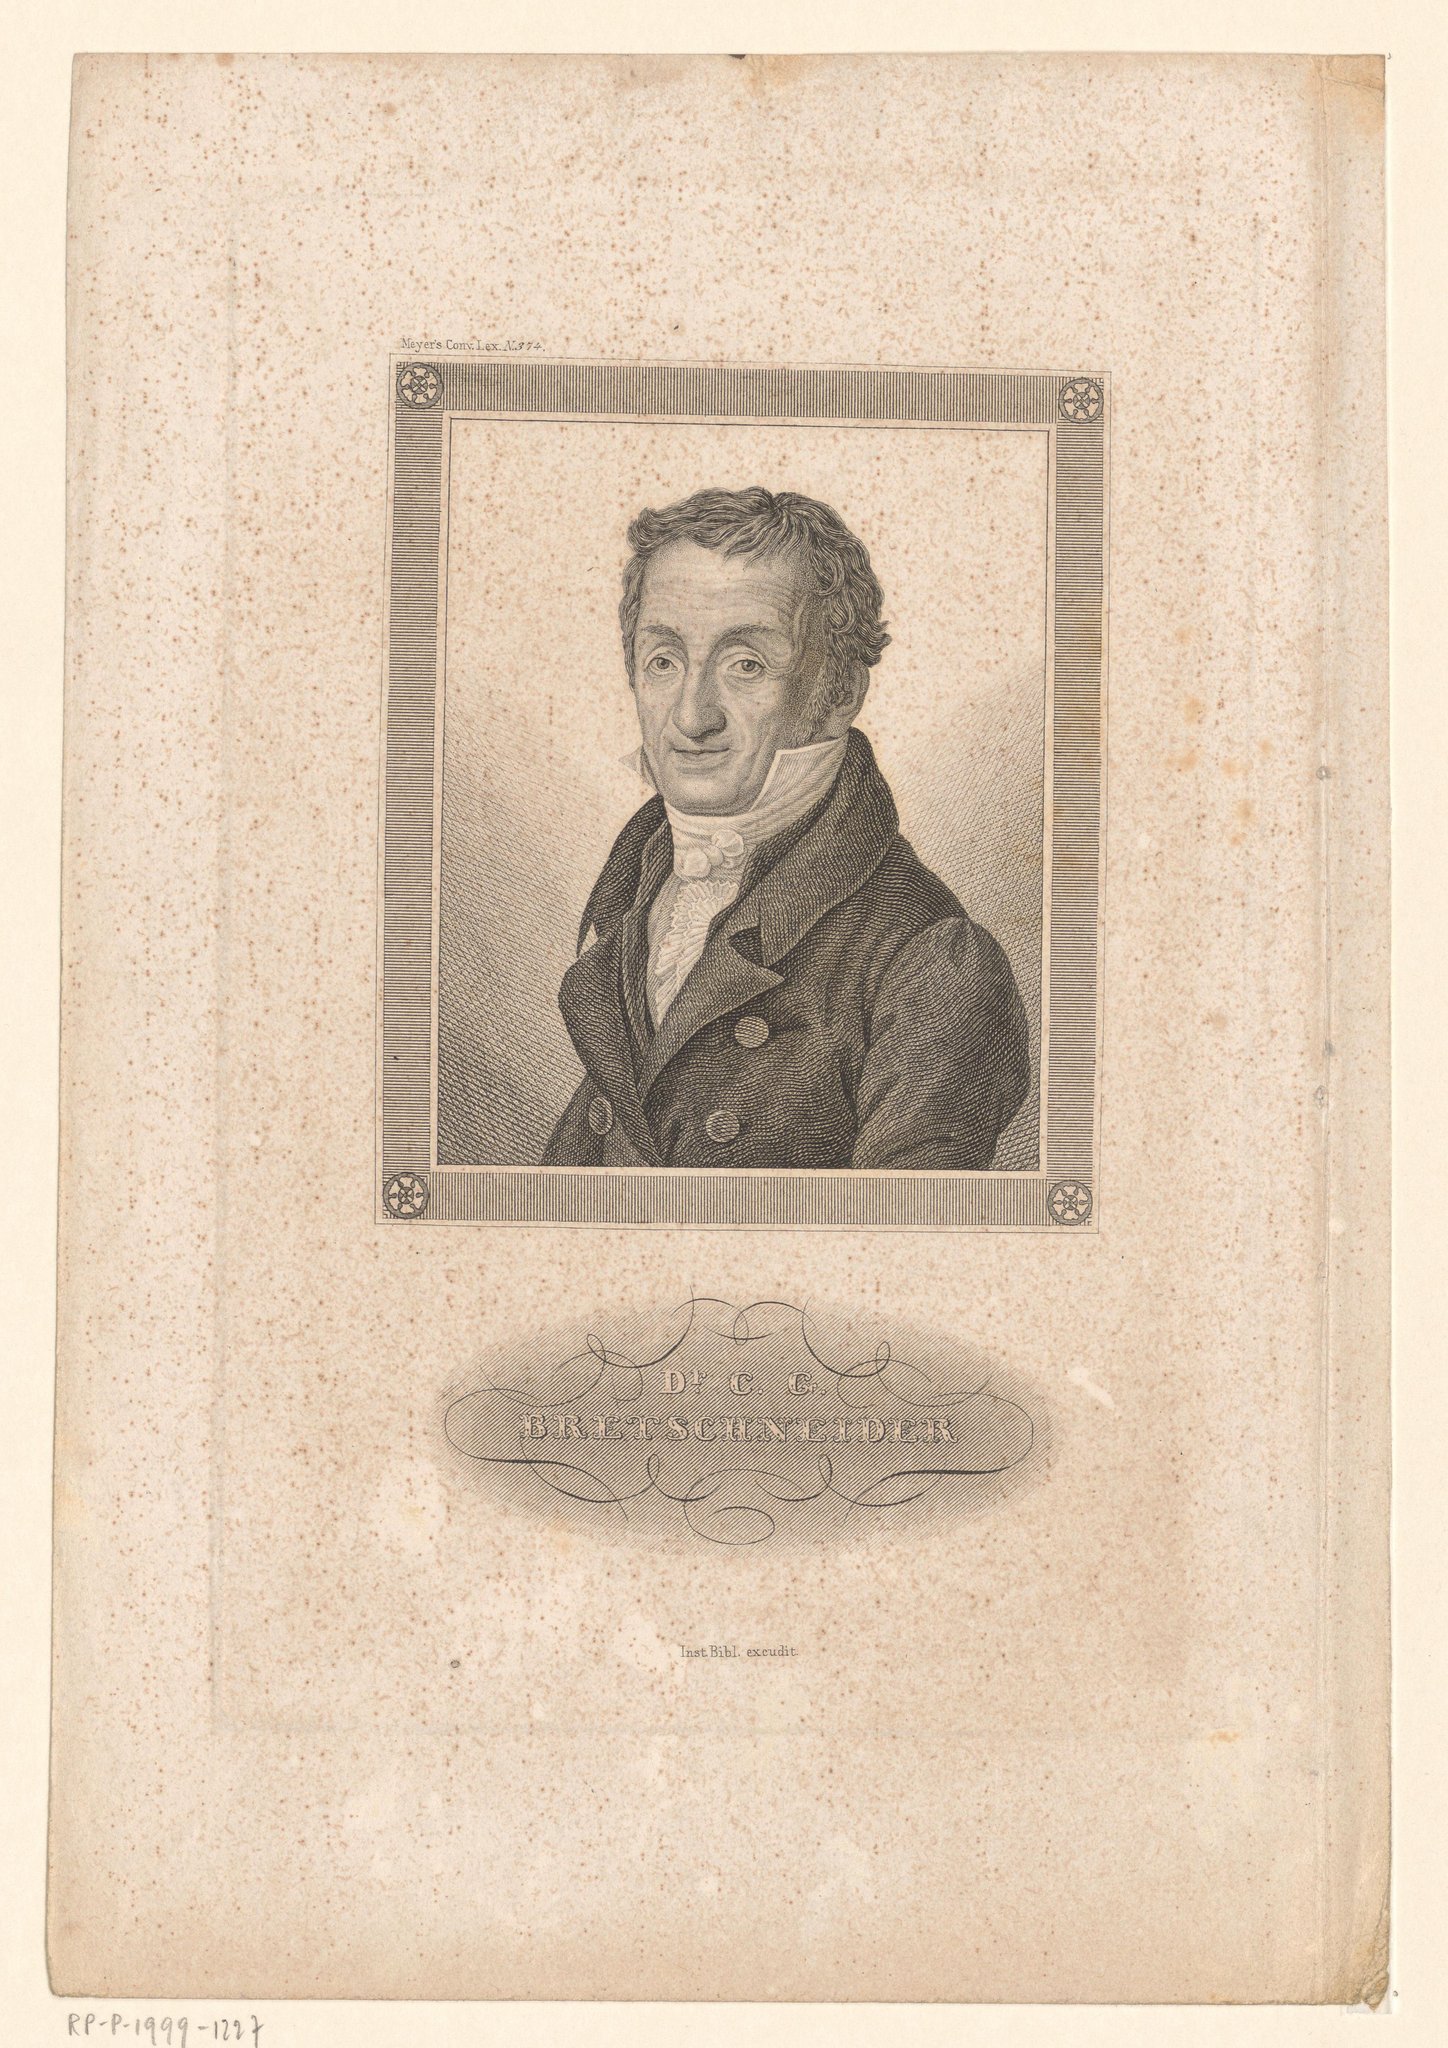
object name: book illustration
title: Portret Karl Gottlieb Bretschneider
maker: Anonymous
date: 1840-1855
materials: paper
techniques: engraving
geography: hildburghausen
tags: zwickau, theologian, historical persons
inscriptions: collector's mark: Lugt 2228, collector's mark: Lugt 2760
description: Prent uit: Meyer, Joseph. Das Grosse Conversations-Lexikon für die gebildeten Stände. Hildburghausen: Bibliographisches Institut, 1840-1855.